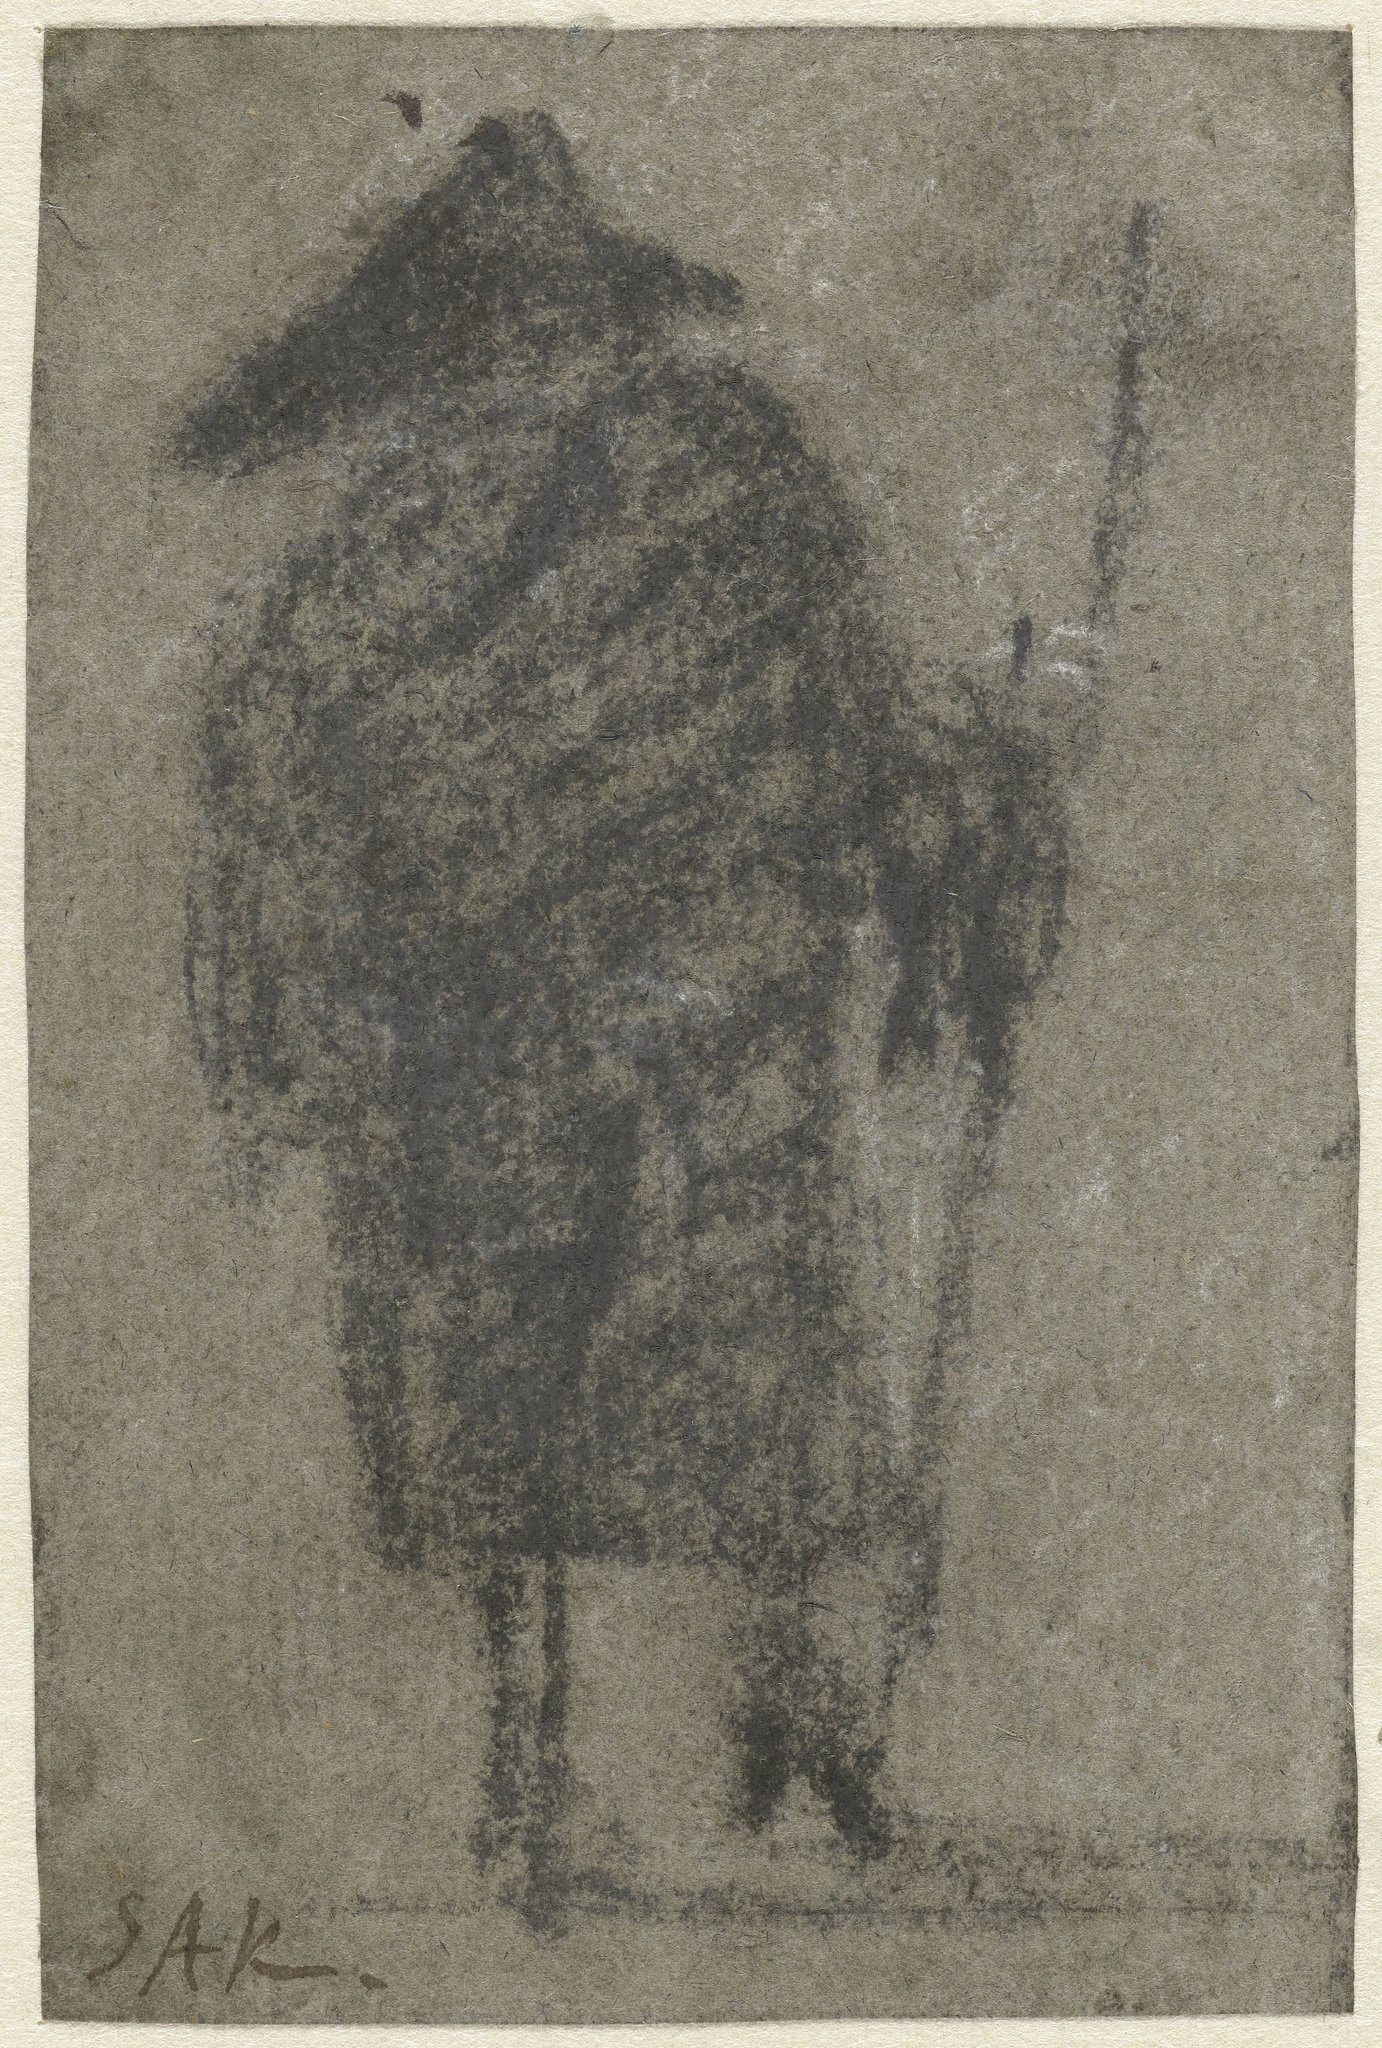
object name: drawing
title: Staande man, op de rug gezien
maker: simon andreas krausz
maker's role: draughtsman, print maker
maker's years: 1760-1825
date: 1770-1825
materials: chalk, paper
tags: caricatures (human types)